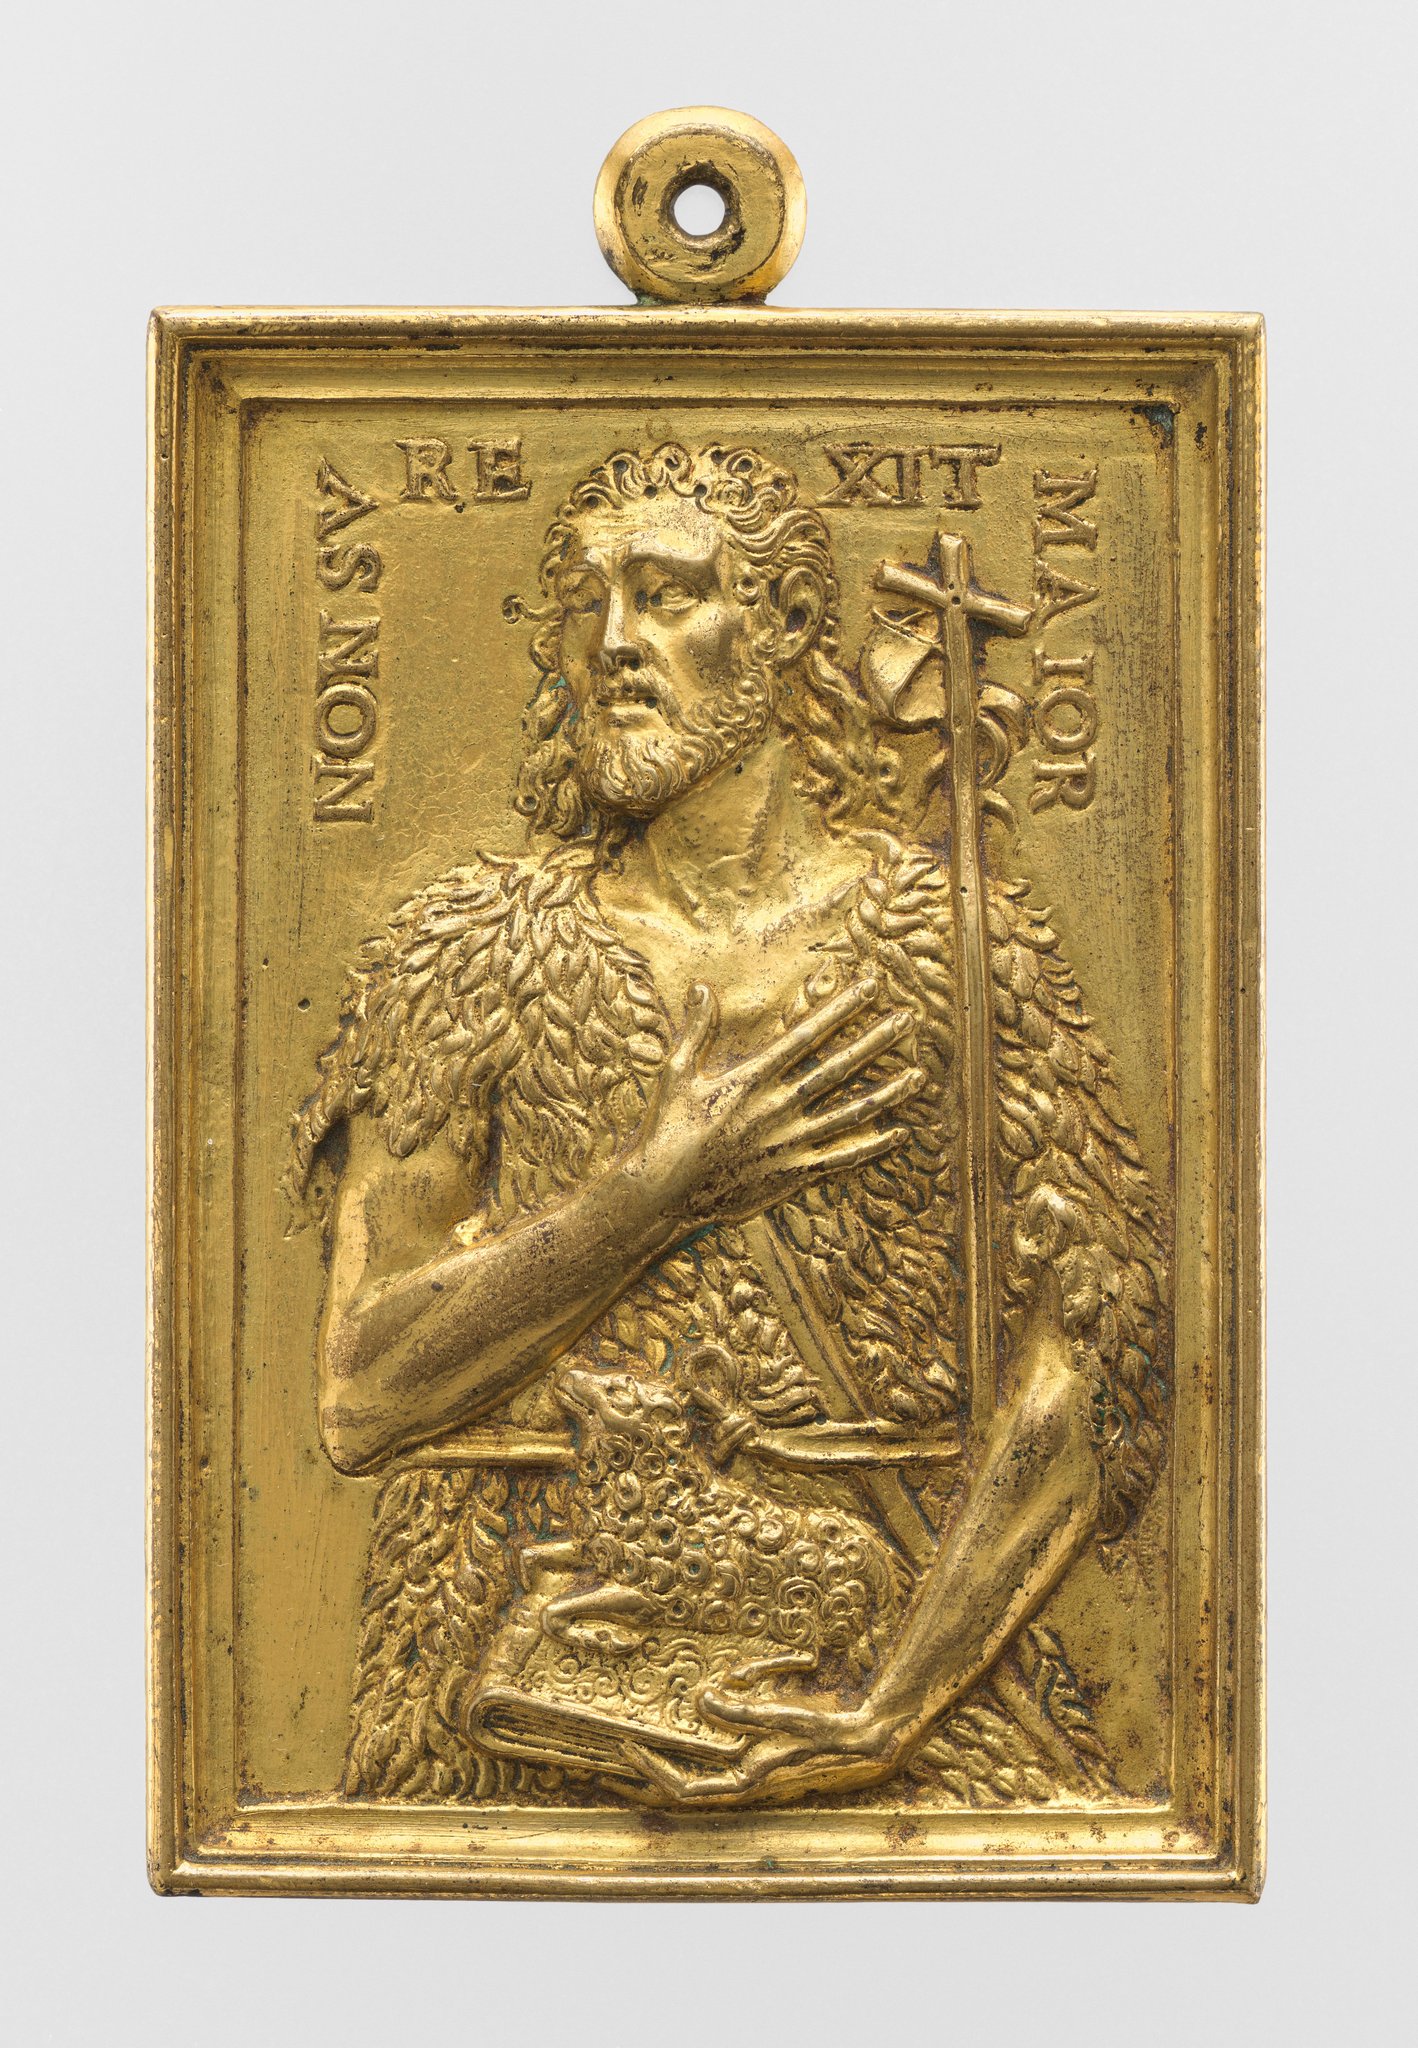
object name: plaquette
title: Saint John the Baptist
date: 1600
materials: gilt bronze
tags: lambs,saint john the baptist,cross